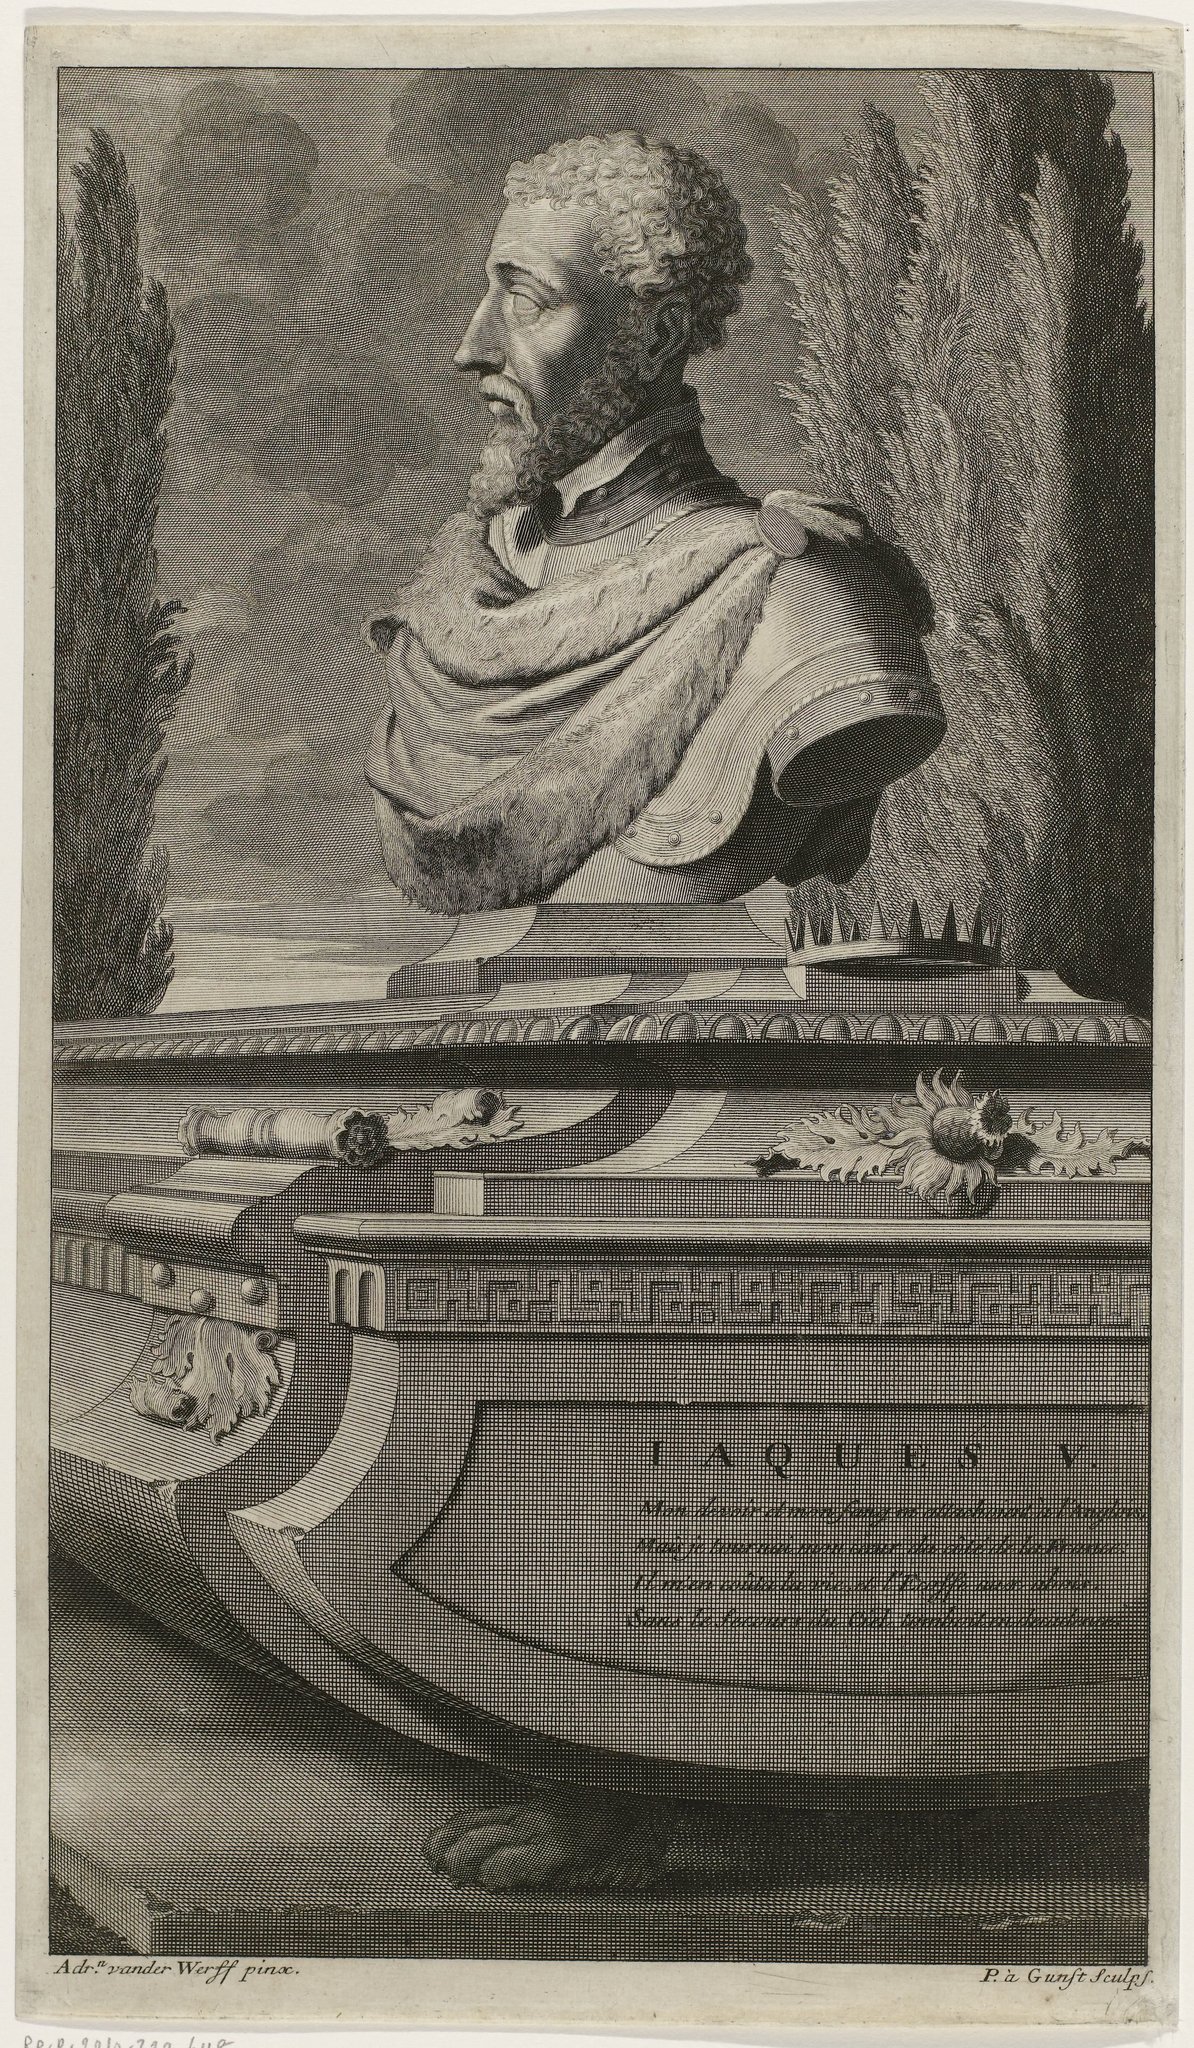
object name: print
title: Portret Jacques V van Schotland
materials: paper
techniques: engraving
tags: jacobus v (koning van schotland)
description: Buste Jacques V (koning van Schotland: 1512-1542) op graftombe waarop 4-regelig vers in het Frans.